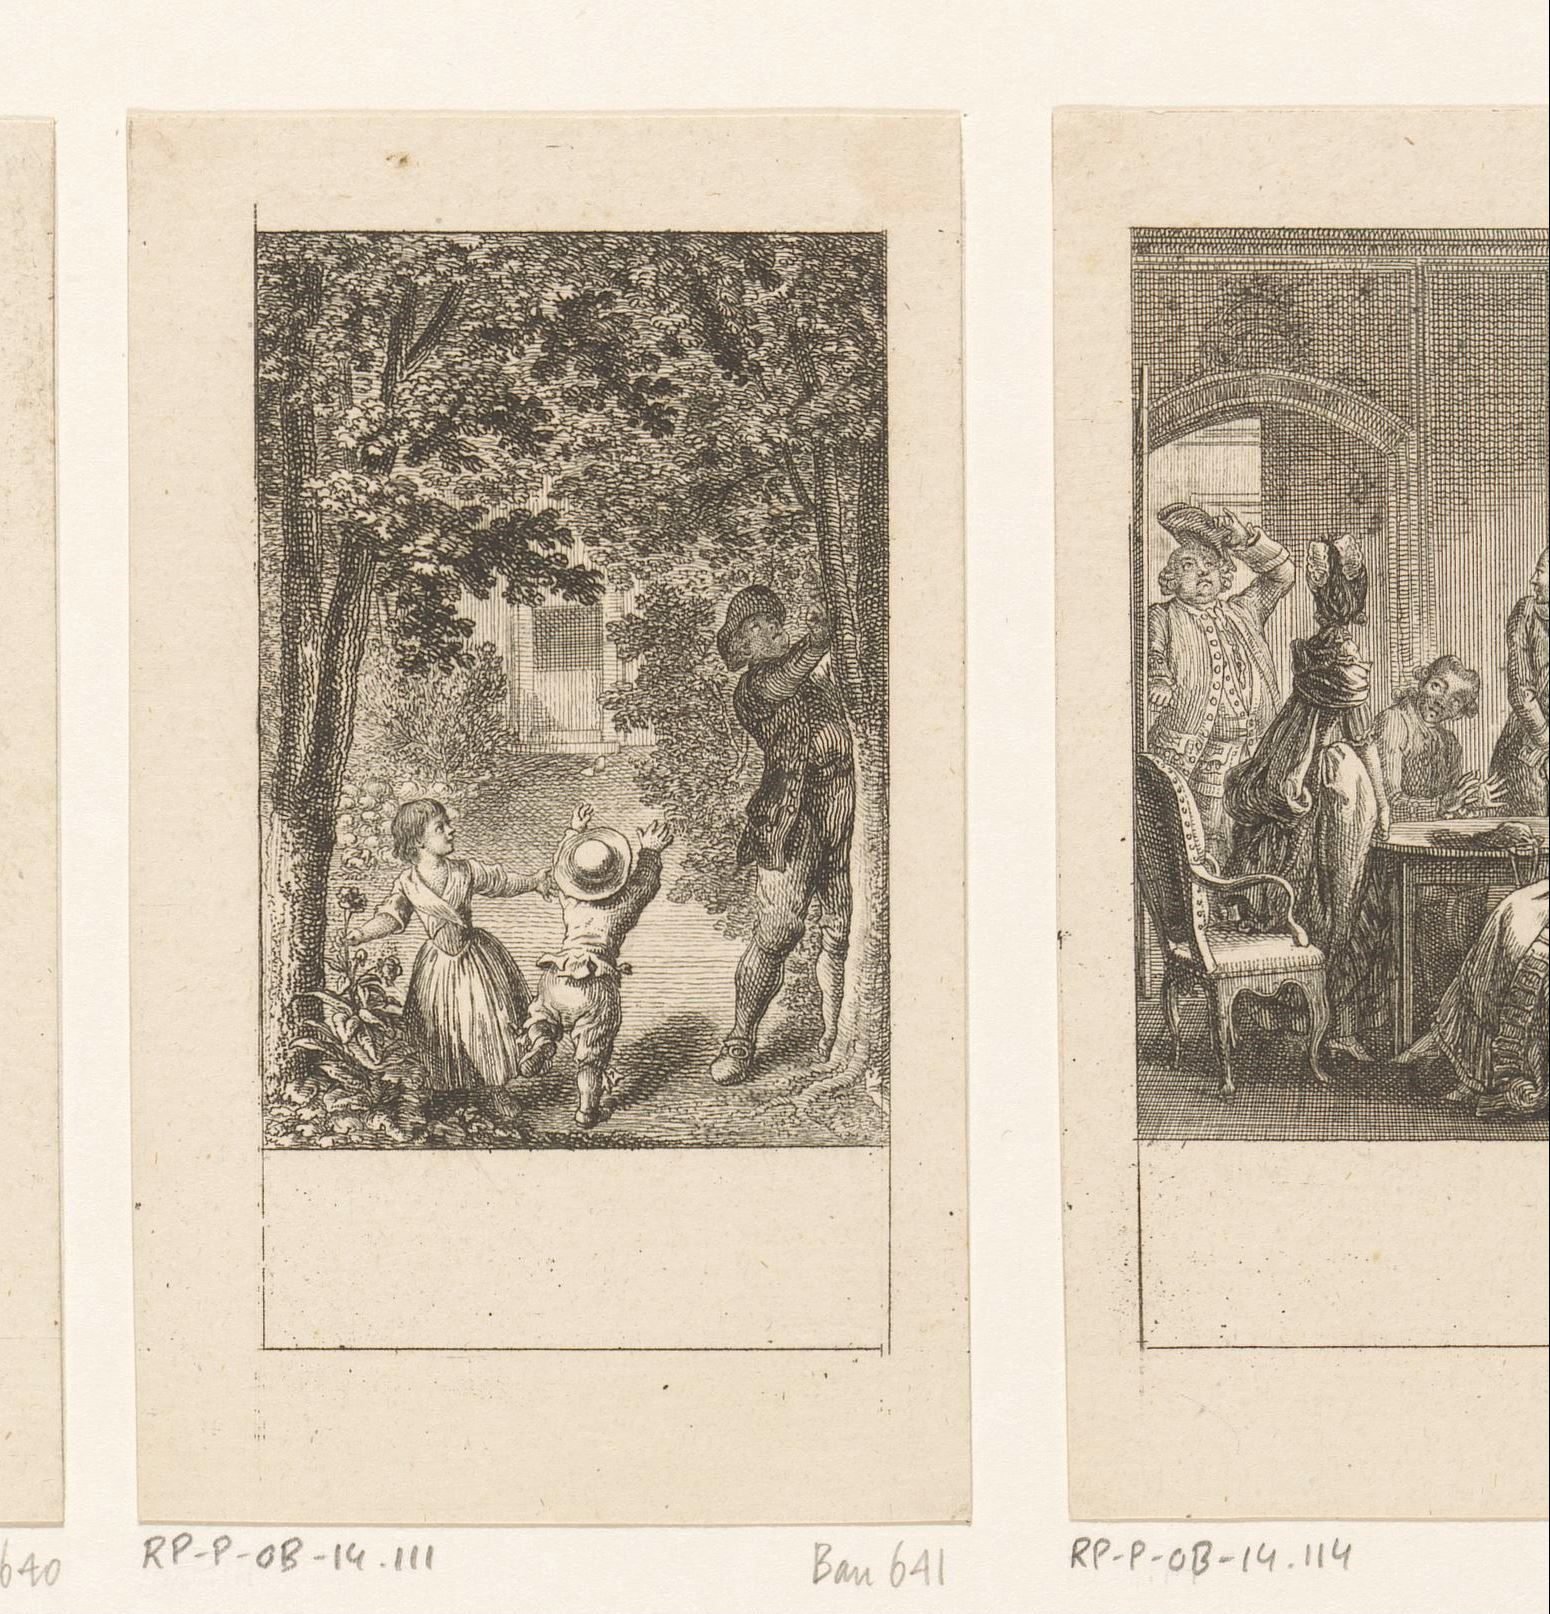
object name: print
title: Man met kinderen in zijn tuin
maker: daniel nikolaus chodowiecki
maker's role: draughtsman, print maker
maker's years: 1726-1801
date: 1779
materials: paper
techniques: etching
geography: berlin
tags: garden, father and child(ren), man and child(ren) (family group)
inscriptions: collector's mark: Lugt 2228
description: Vijfde prent afkomstig uit een serie van twaalf verschillende prenten. De scènes zijn op een plaat geëtst. Een latere staat van deze serie is ook gebruikt in: Lauenburger genealogischen Kalender auf das Jahr 1780.